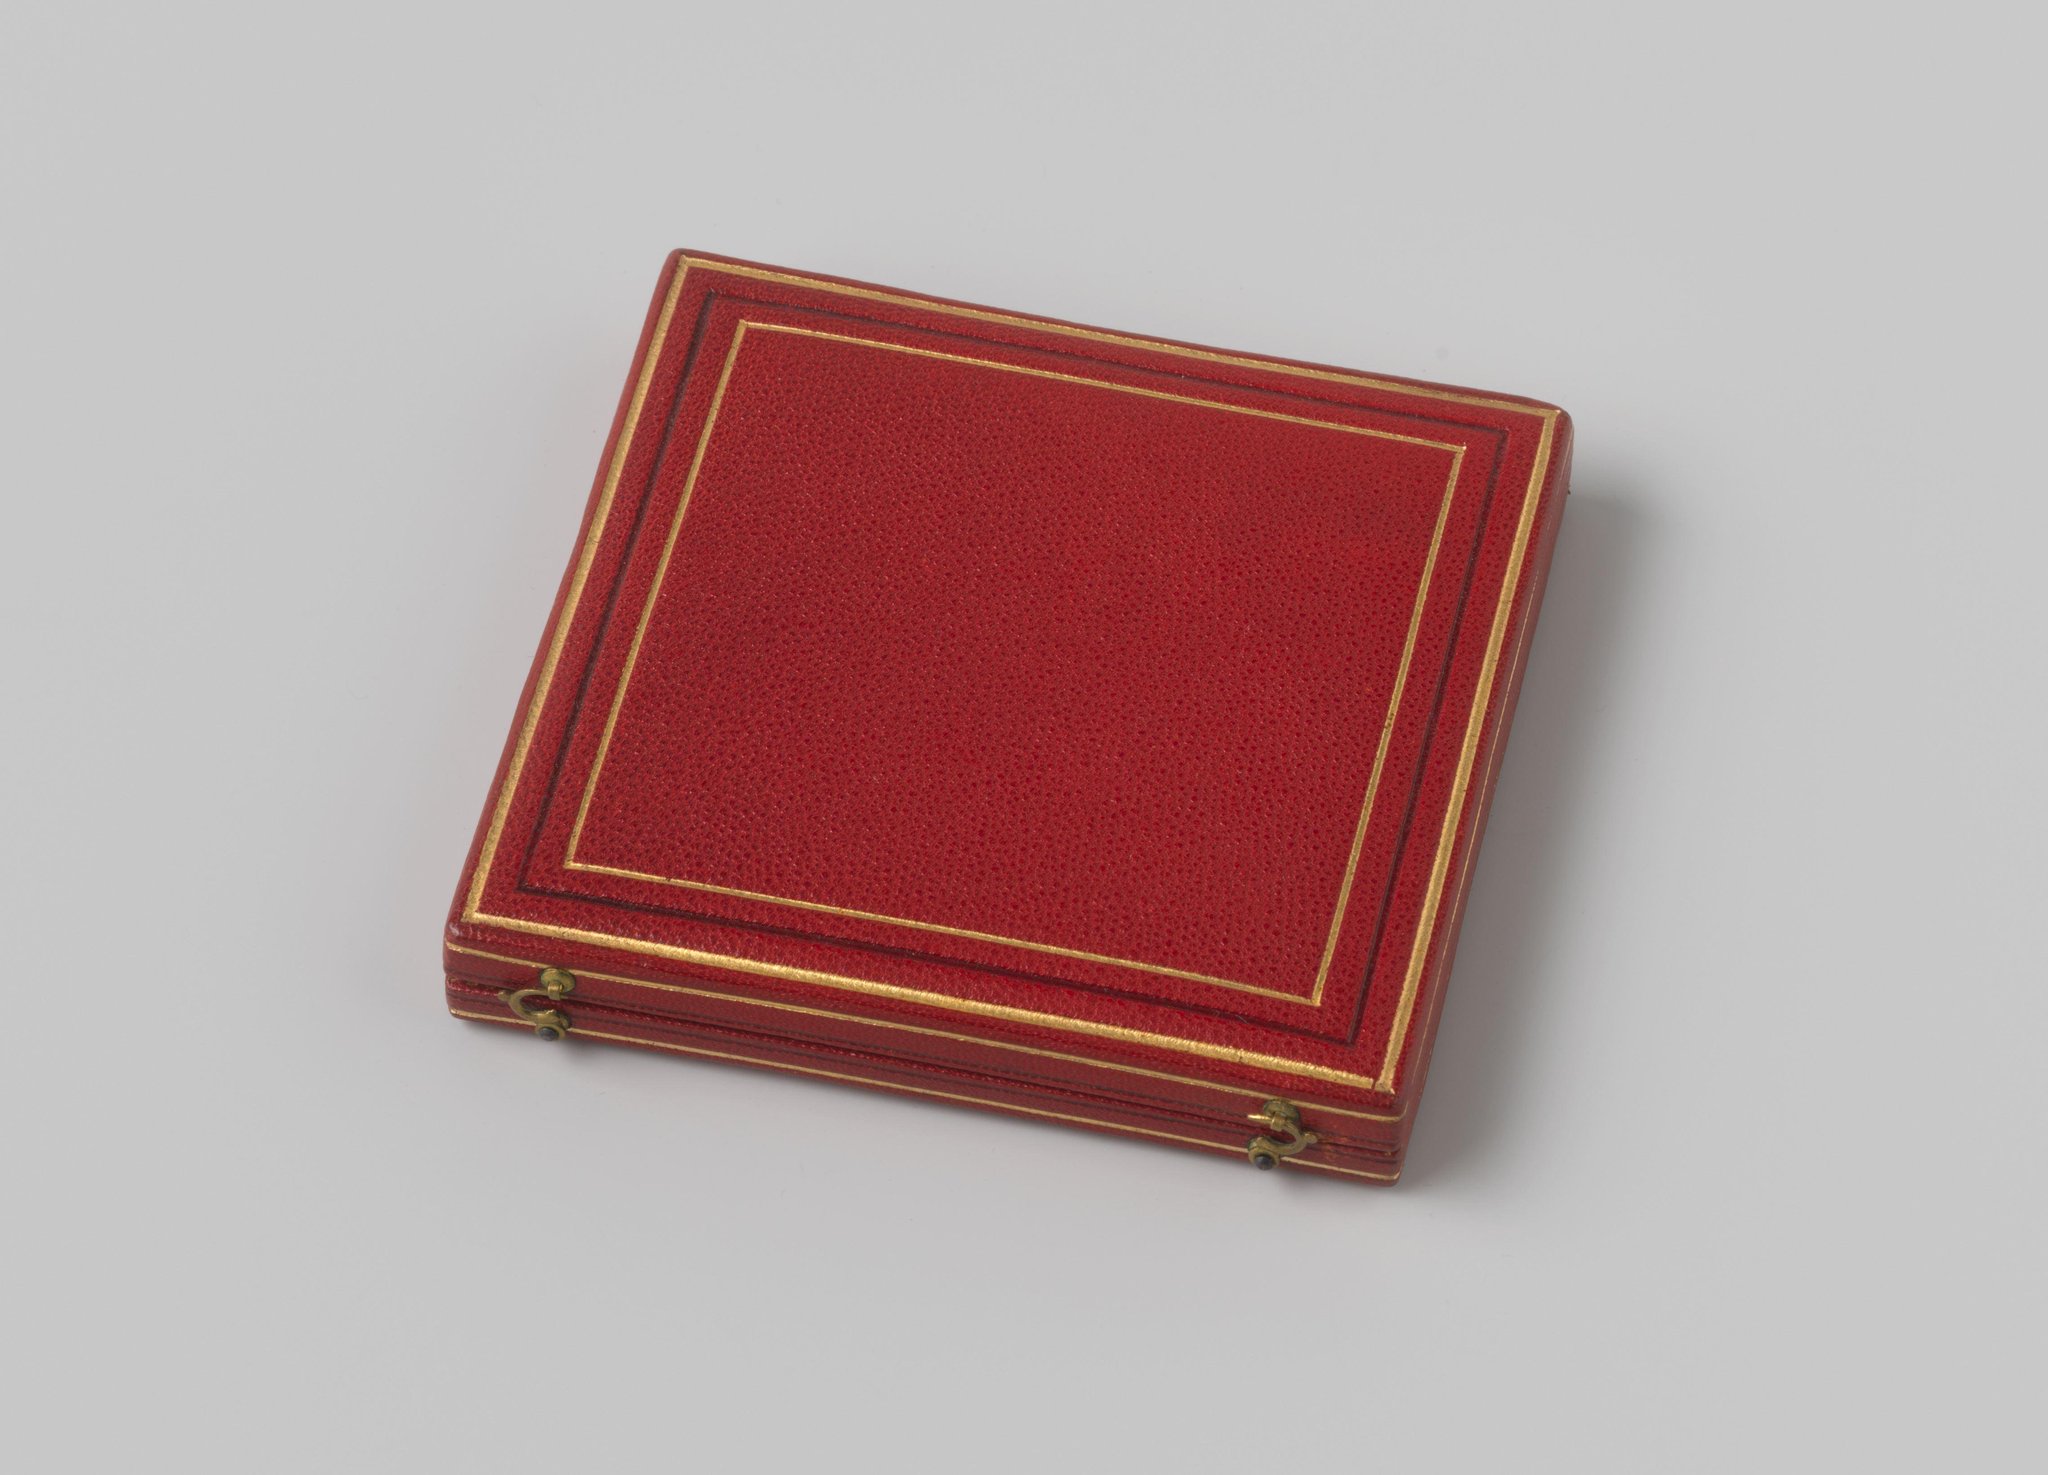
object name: box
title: Penningdoos van rood leer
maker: Anonymous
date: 1800-1900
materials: leather, velvet, wood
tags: william ii (prince of orange), the hague, amsterdam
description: Rood leren penningdoosje uit de 19e eeuw behorend bij een zilveren penning.